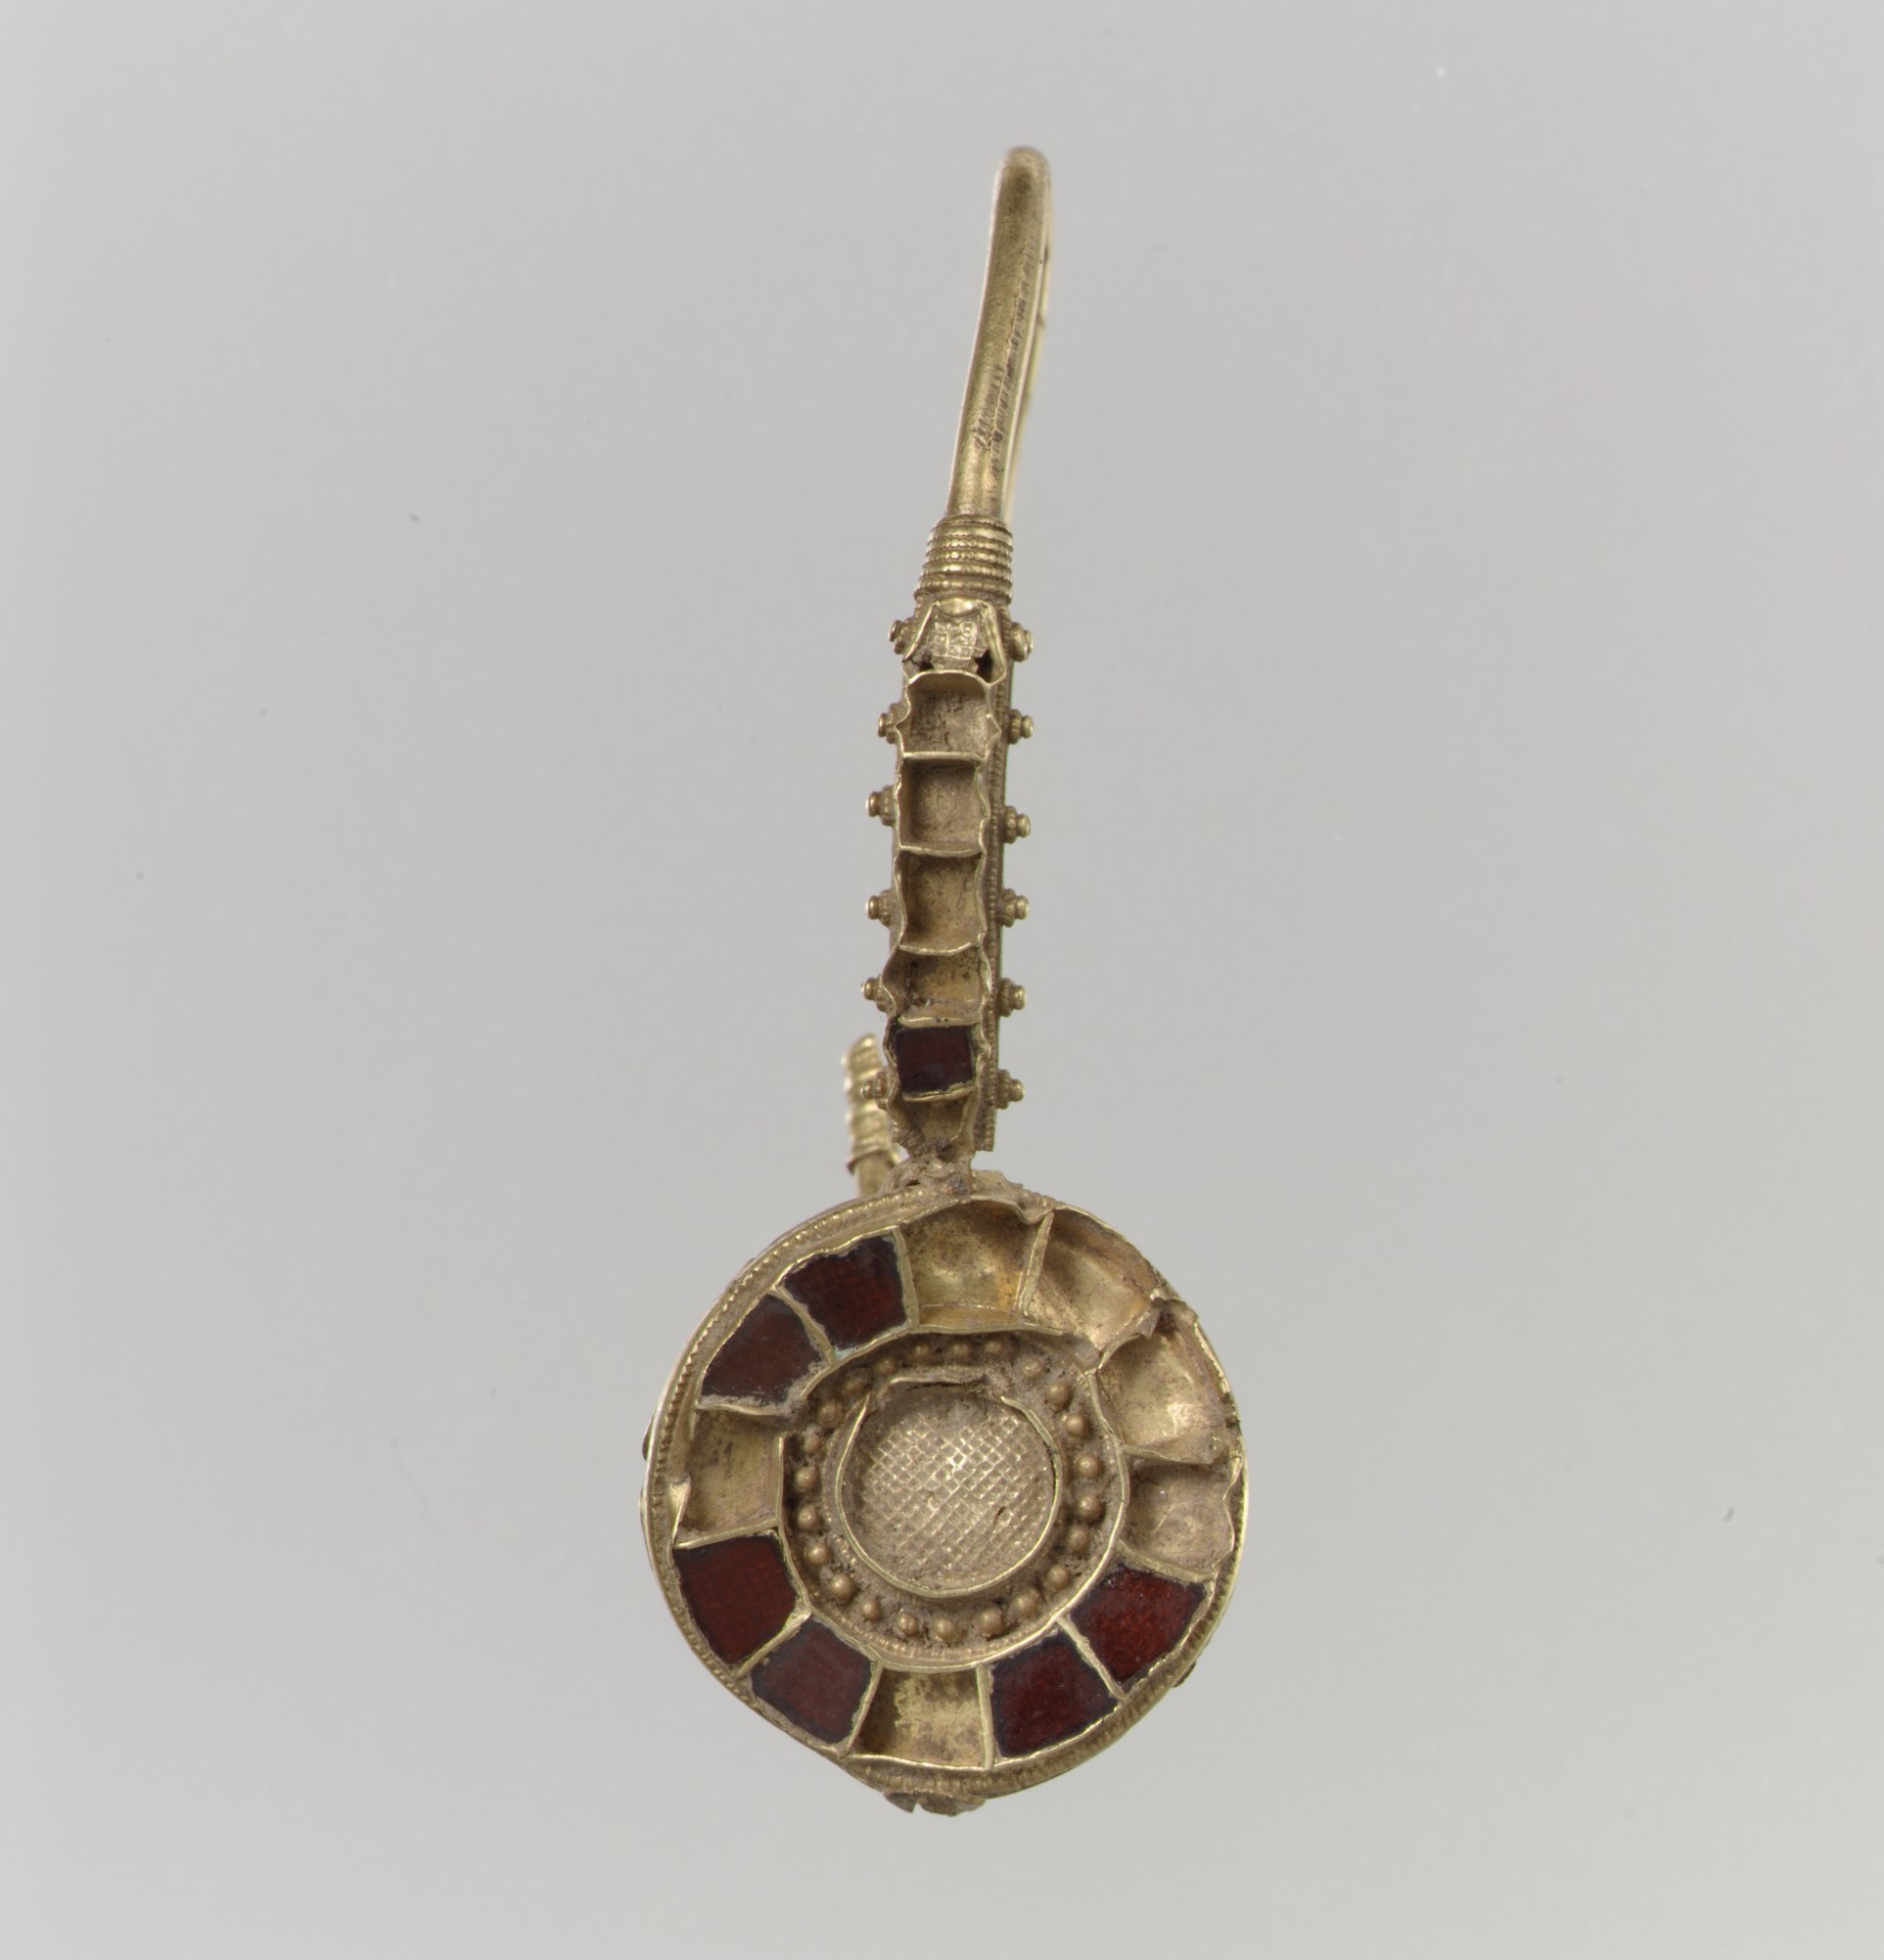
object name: earring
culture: byzantine or langobardic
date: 501-700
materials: garnet, gold